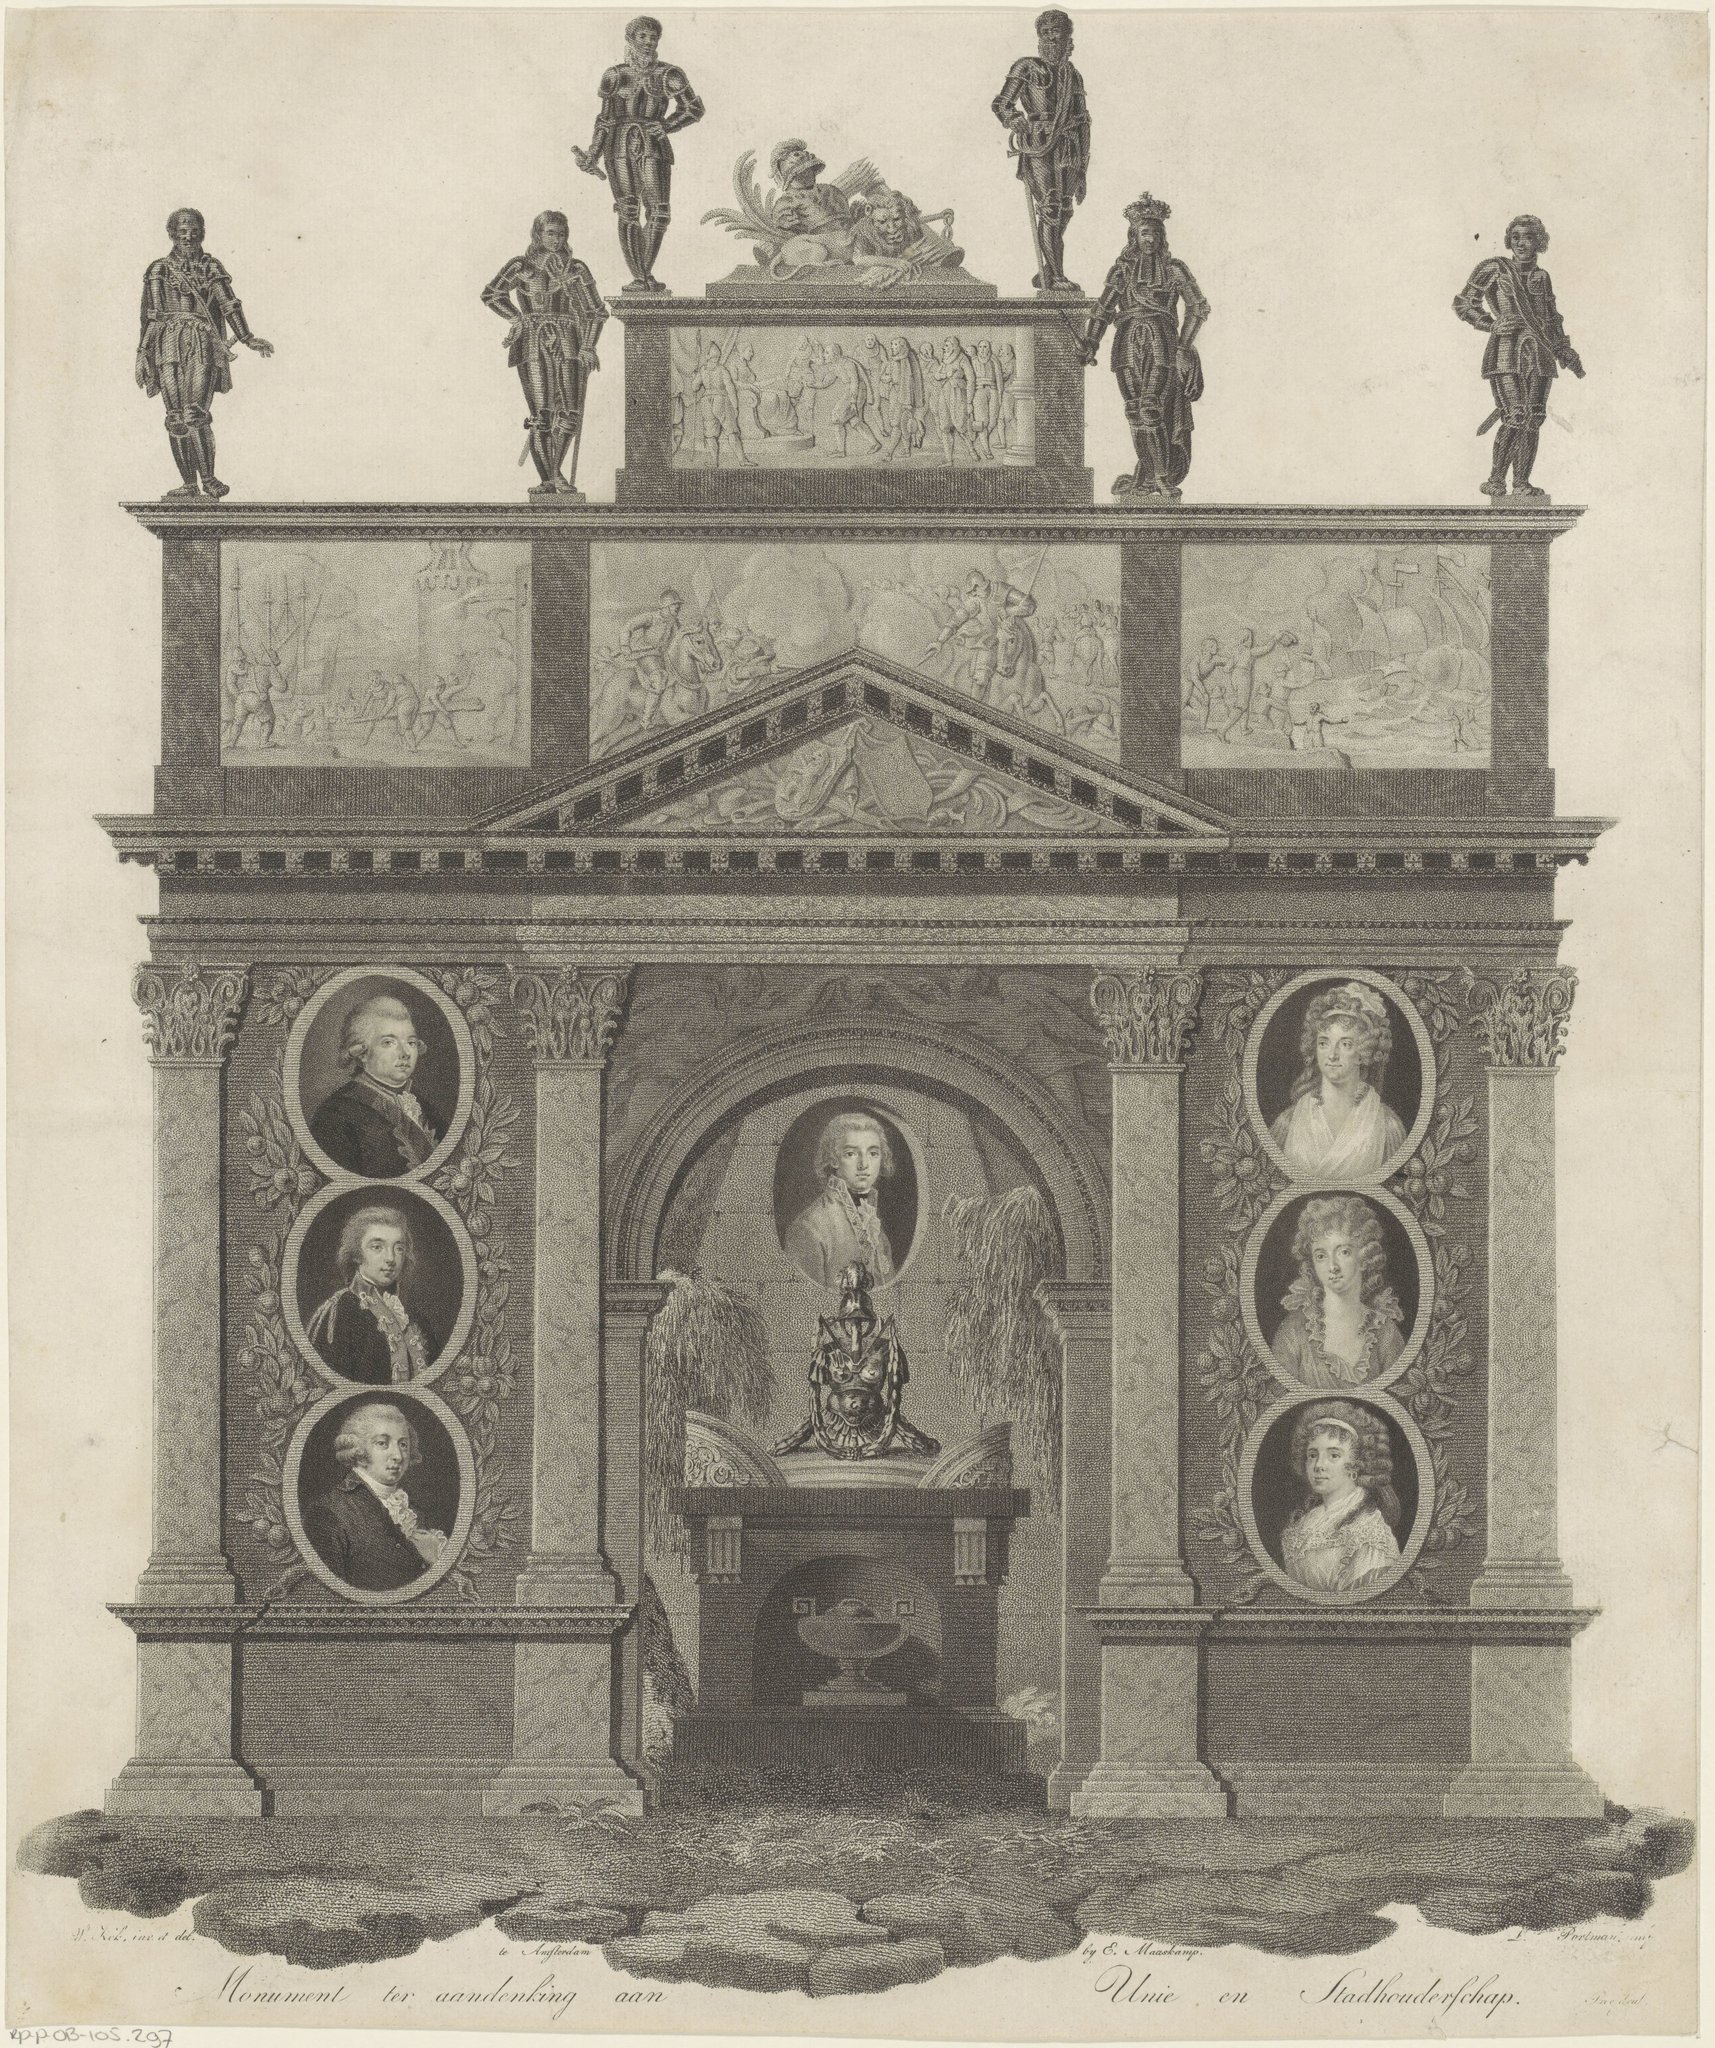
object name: print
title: Monument ter aandenking aan het stadhouderschap in de Nederlanden, 1806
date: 1806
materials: paper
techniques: engraving, etching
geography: amsterdam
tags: william v (prince of orange), william i of the netherlands, william iii (prince of orange and king of england, scotland, and ireland), frederick henry (prince of orange), william ii (prince of orange), delft, william i (prince of orange), maurice (prince of orange), karel van brunswijk-wolfenbüttel, painter, wilhelmina of prussia (princess of orange), willem iv (prins van oranje-nassau), louise (prinses van oranje-nassau), willem george frederik (prins van oranje-nassau), berlin, the hague, wilhelmina frederica louisa (koningin der nederlanden), monument, statue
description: Monument ter aandenking aan het stadhouderschap in de Nederlanden, waarschijnlijk bij gelegenheid van het overlijden van Willem V in 1806. Bovenop het monument standbeelden van zes stadhouders van Willem I tot en met Willem IV. Op het monument voorstellingen van historische gebeurtenissen. Centraal in de poort het grafmonument van Frederik (overleden in 1799). Hieromheen portretten van Willem V en zijn echtgenote Wilhelmina, zoon Willem I Frederik met zijn echtgenote Wilhelmina, zijn dochter Louise met haar man Karel . Rechtsonder 'Proefdruk'.